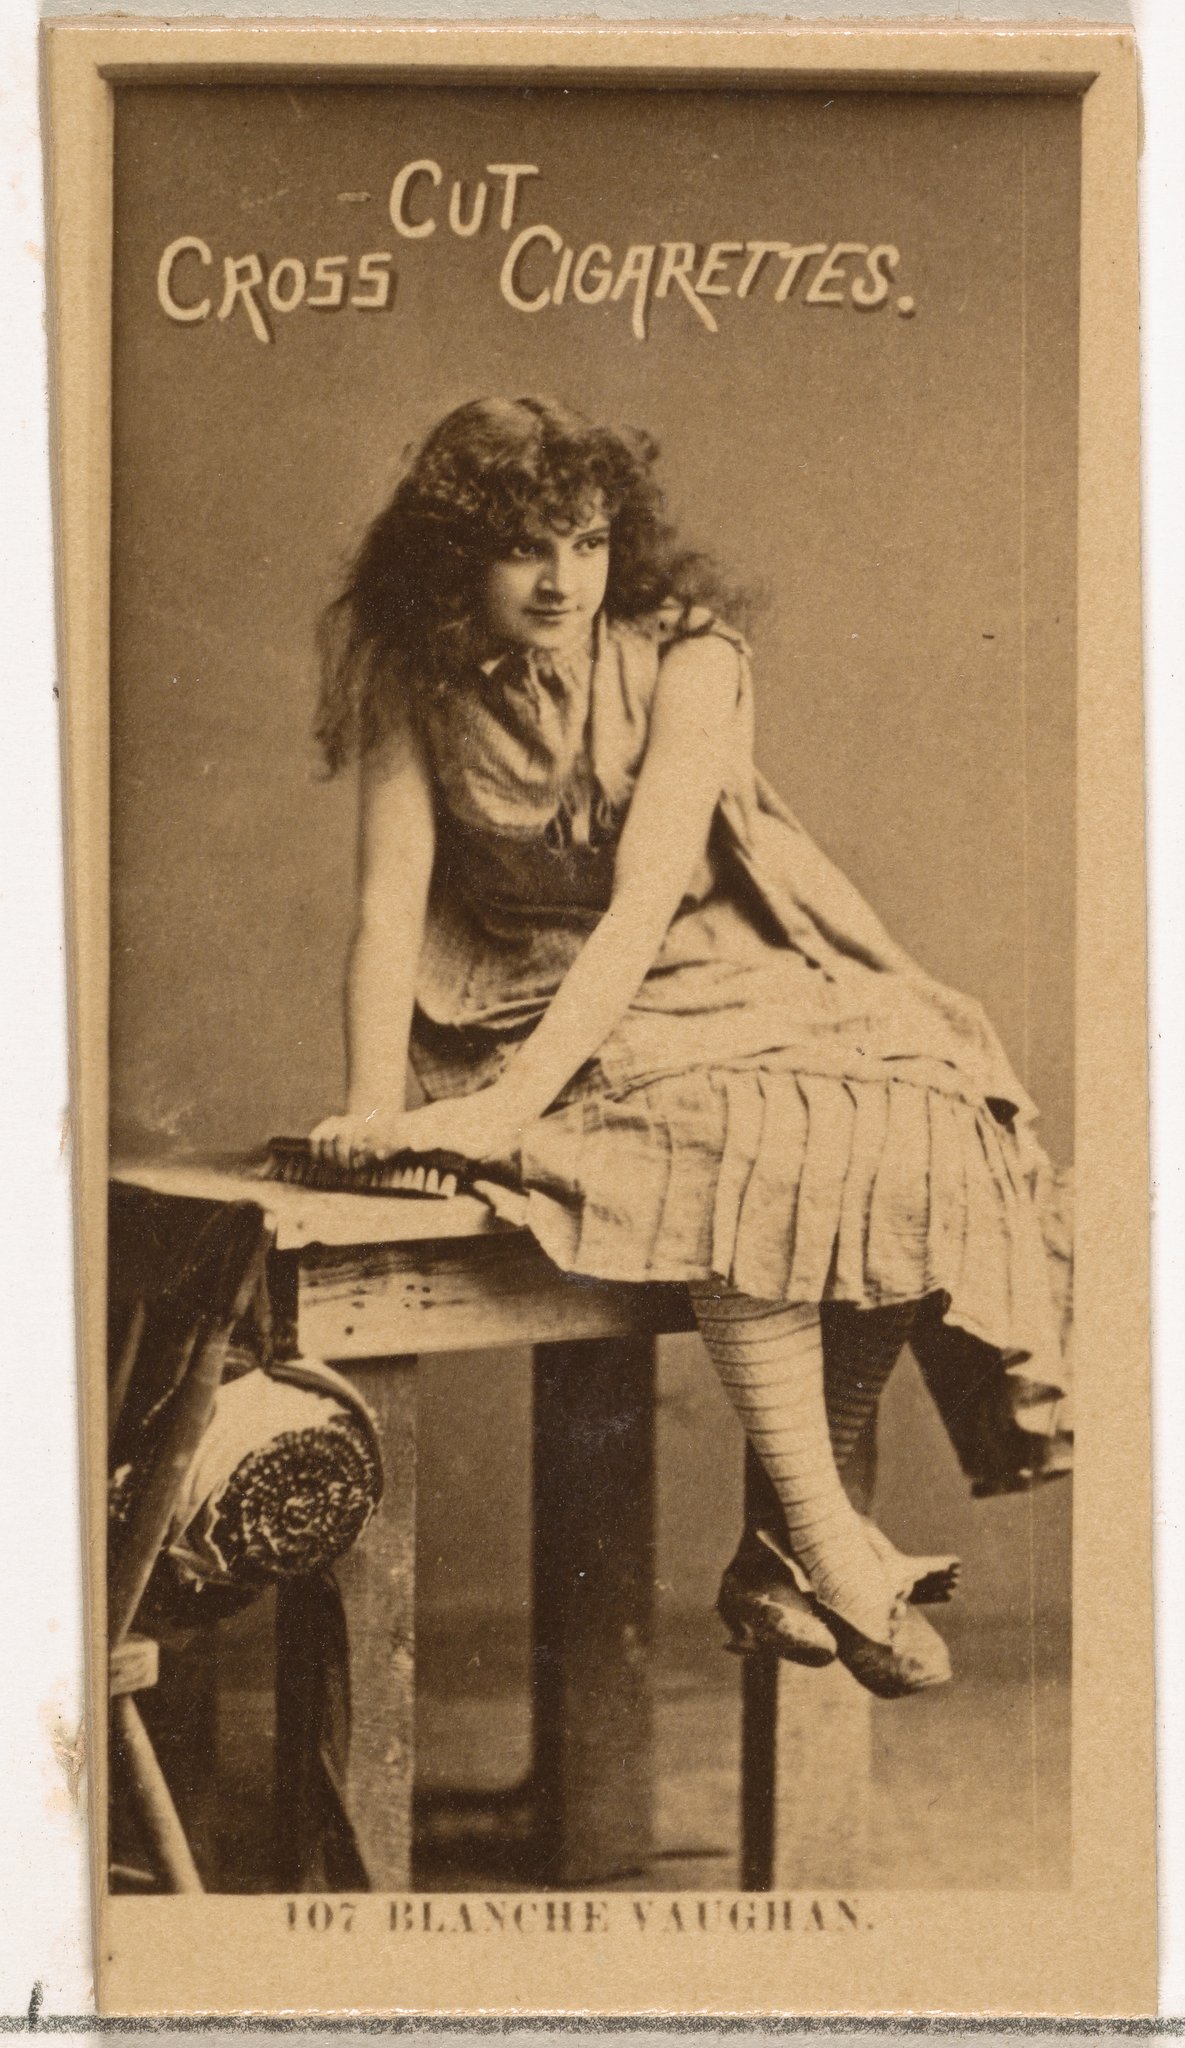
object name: print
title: Card Number 107, Blanche Vaughan, from the Actors and Actresses series (N145-2) issued by Duke Sons & Co. to promote Cross Cut Cigarettes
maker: w. duke, sons & co.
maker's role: publisher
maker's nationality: american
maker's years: 1870-1920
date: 1880-1889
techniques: albumen silver print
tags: portraits,women,actresses